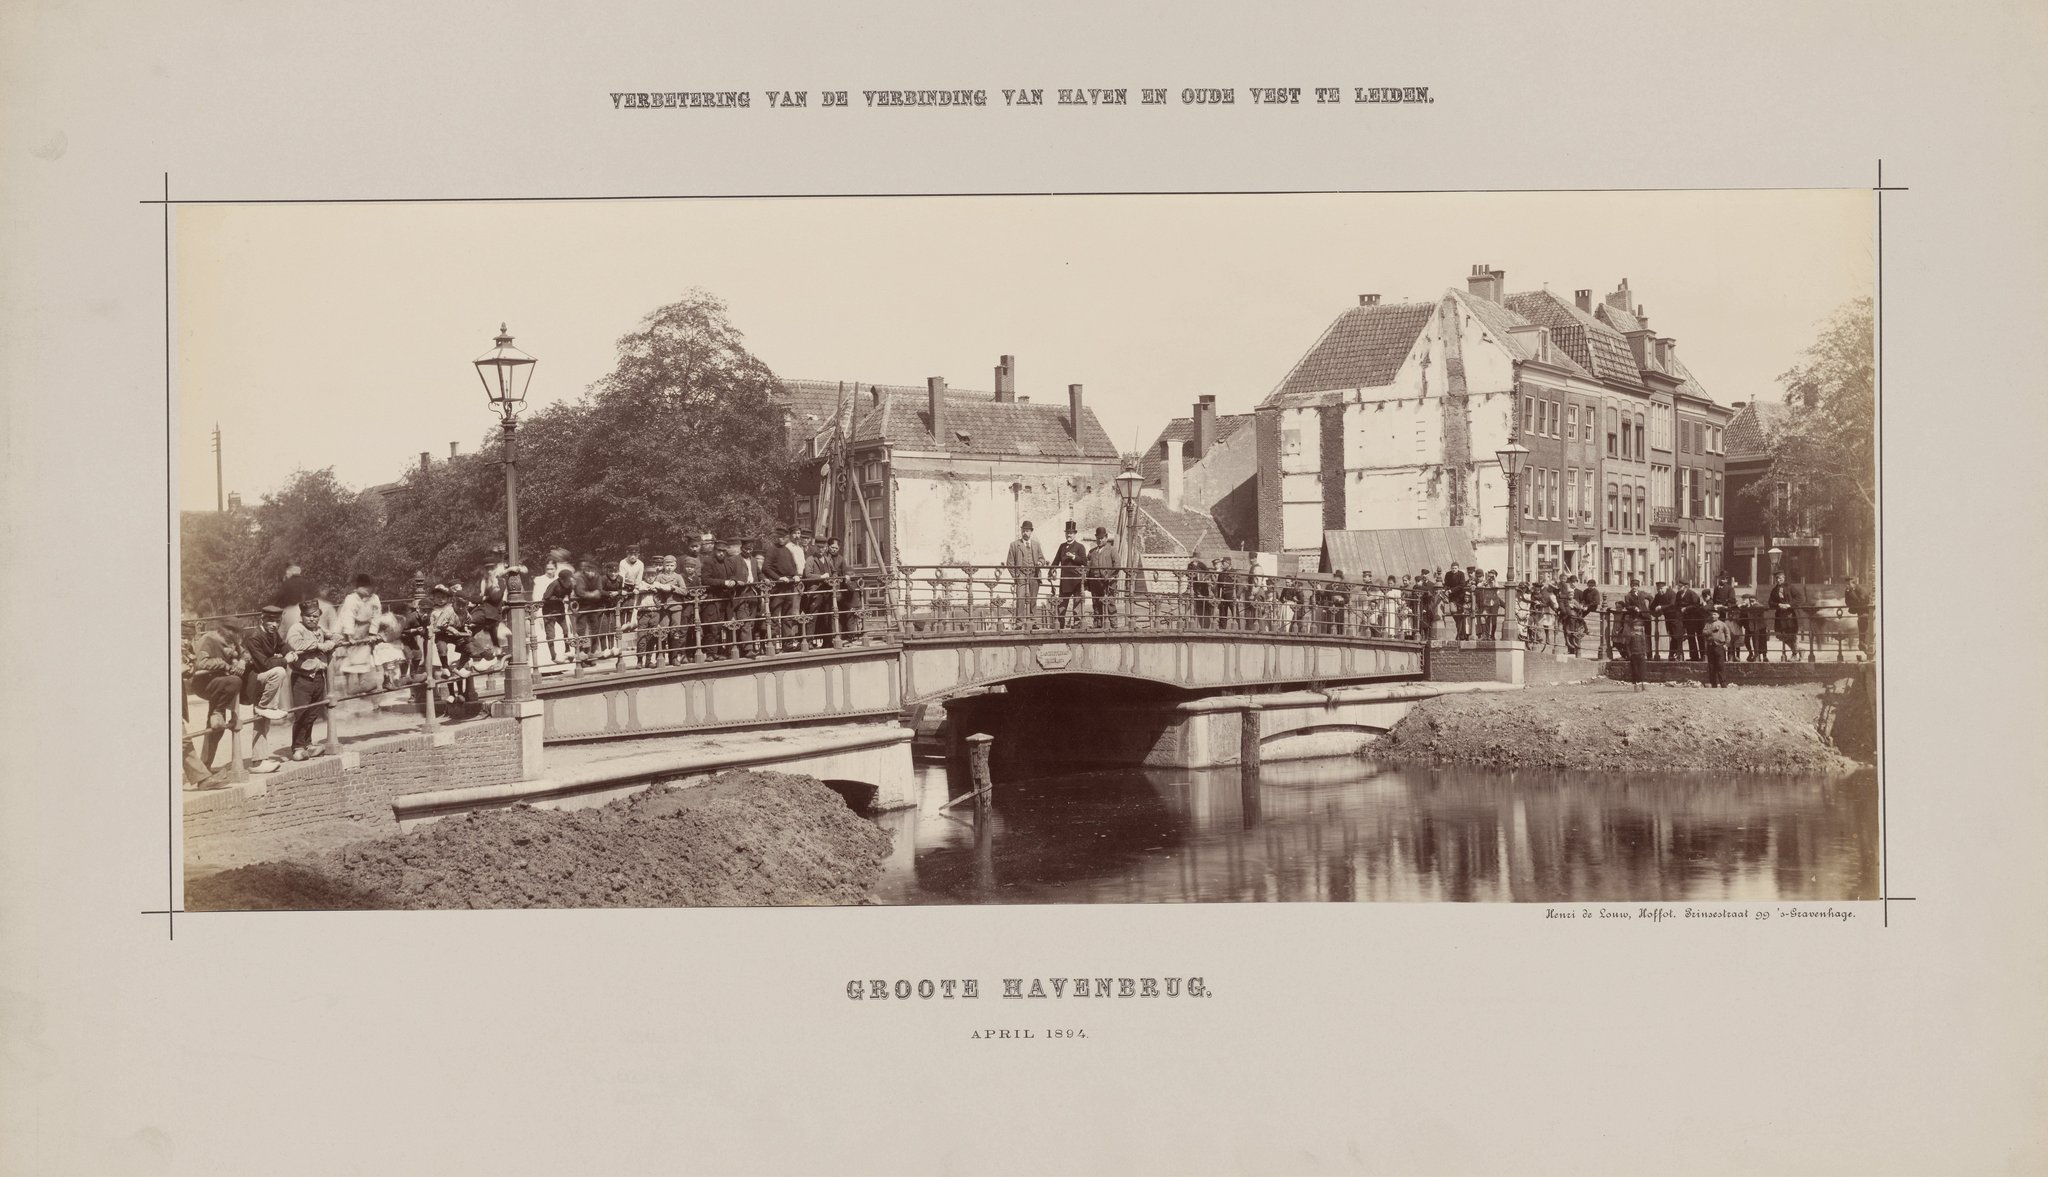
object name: photograph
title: Grote Havenbrug te Leiden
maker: henri de louw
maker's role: fotograaf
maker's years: 1851-1944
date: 1804-1894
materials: cardboard, photographic support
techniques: albumen print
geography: the hague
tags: bridge in city across river, canal, etc.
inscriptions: date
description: Grote Havenbrug te Leiden in de oude situatie voor de plaatsing van de dubbele ophaalbrug in 1894-1895